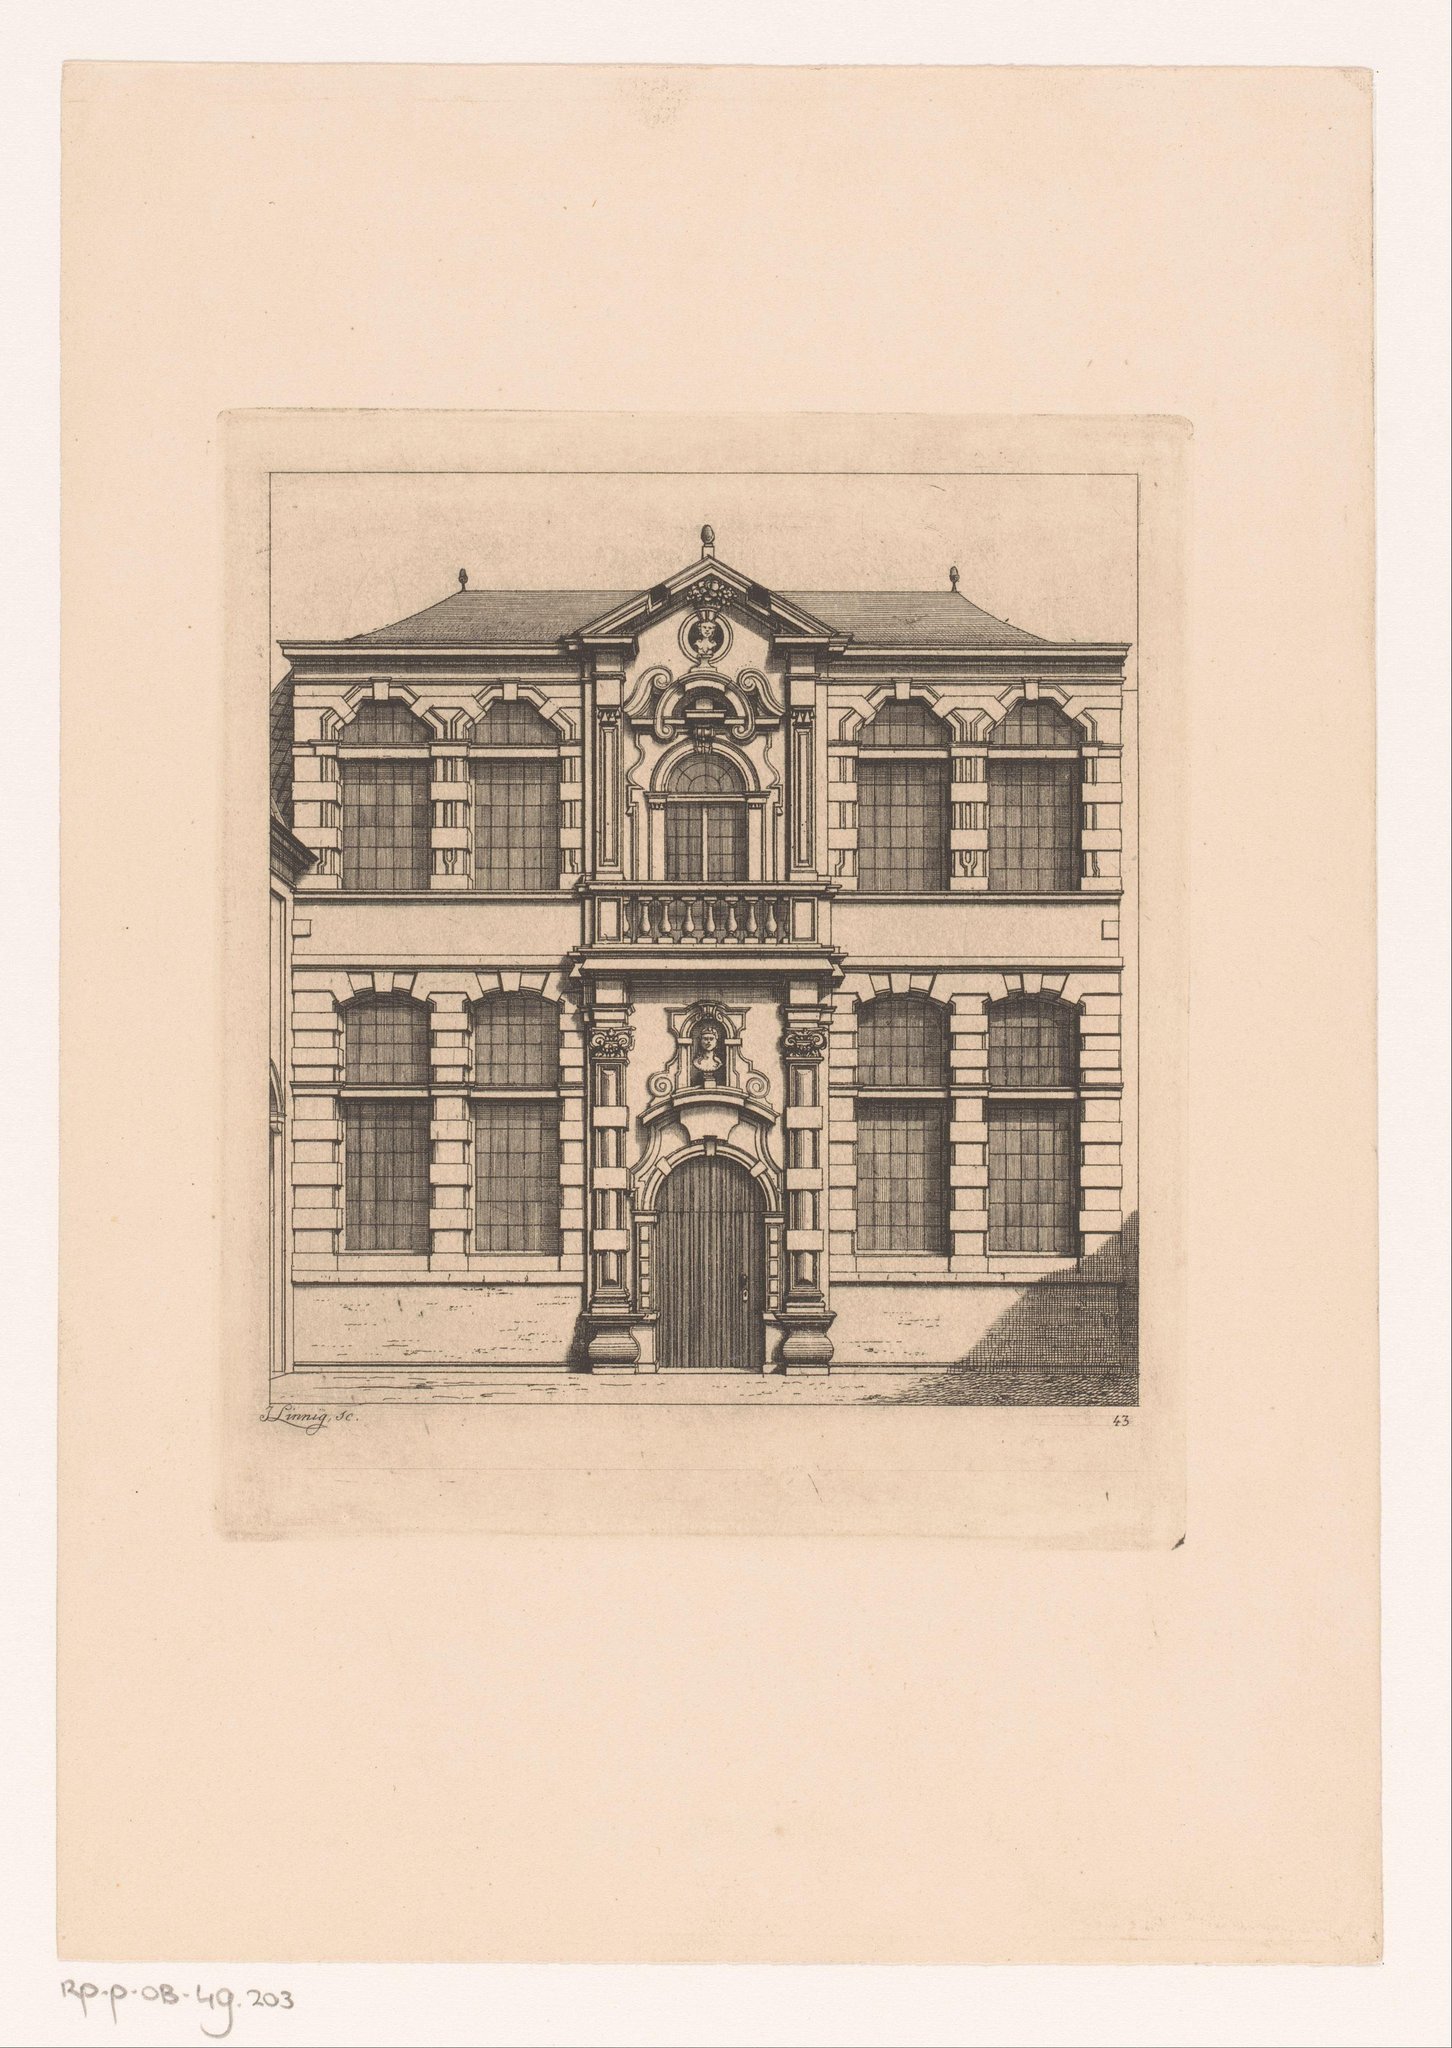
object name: book illustration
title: Gevel van het atelier van Jacques Jordaens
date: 1868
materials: paper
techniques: etching, intaglio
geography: antwerp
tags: workshop, studio ~ painter, façade (of house or building), antwerp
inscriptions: collector's mark: Lugt 2228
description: Prent uit: Mertens, F.H. Album historique de la ville d'Anvers [...]. Antwerpen: J.E. Buschmann, 1868.